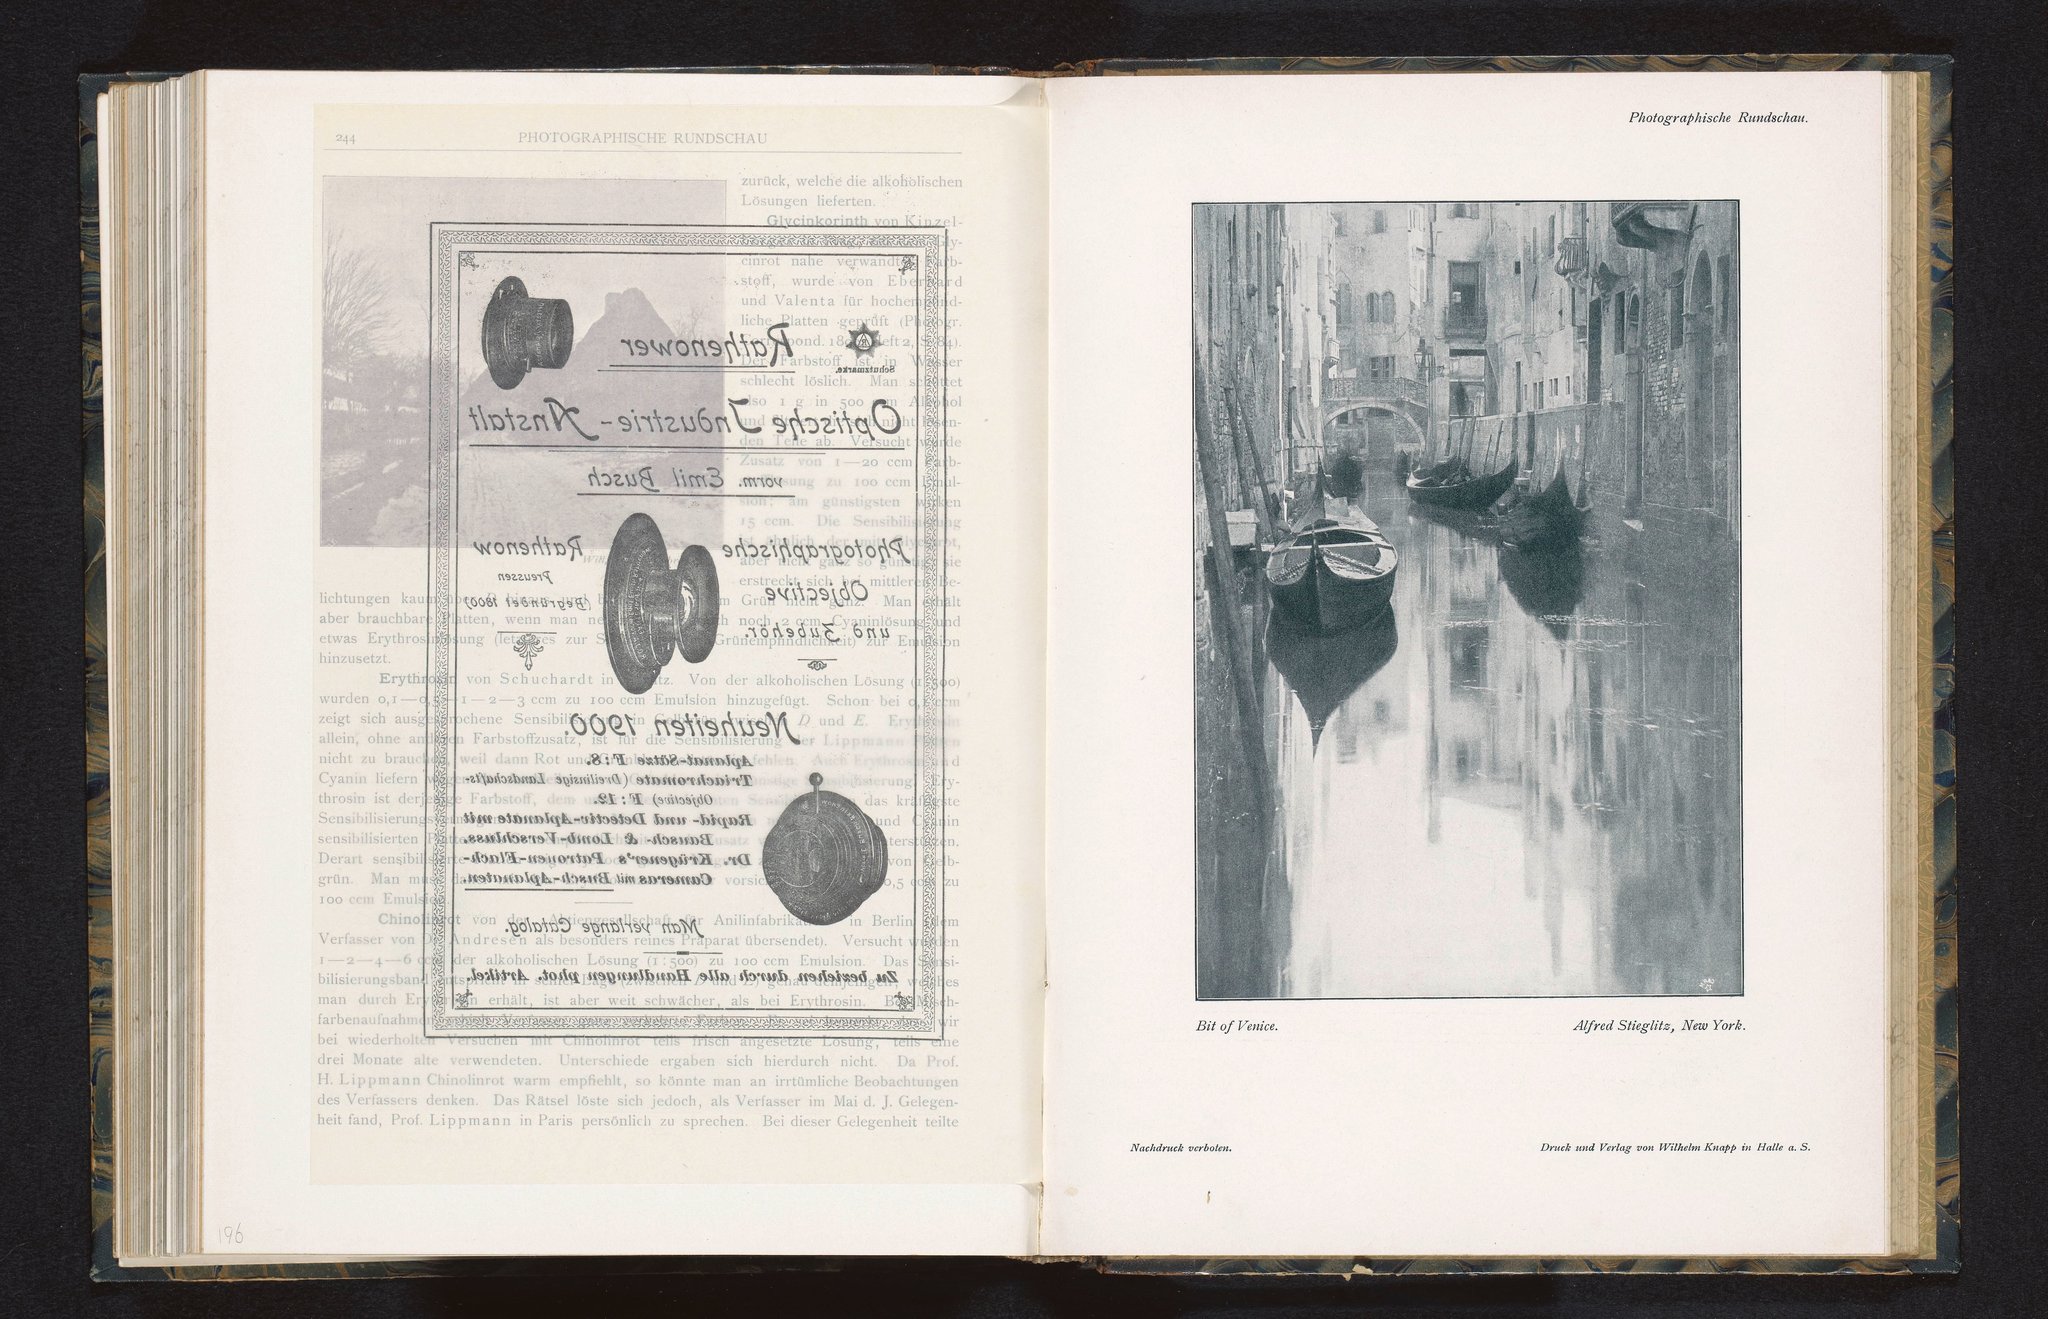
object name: page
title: Bit of Venice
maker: alfred stieglitz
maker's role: fotograaf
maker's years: 1864-1946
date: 1895-1900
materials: paper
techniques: autotype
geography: berlin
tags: bridge, gondola, small canal, ditch, venice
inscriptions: monogram: ‘MR&C’